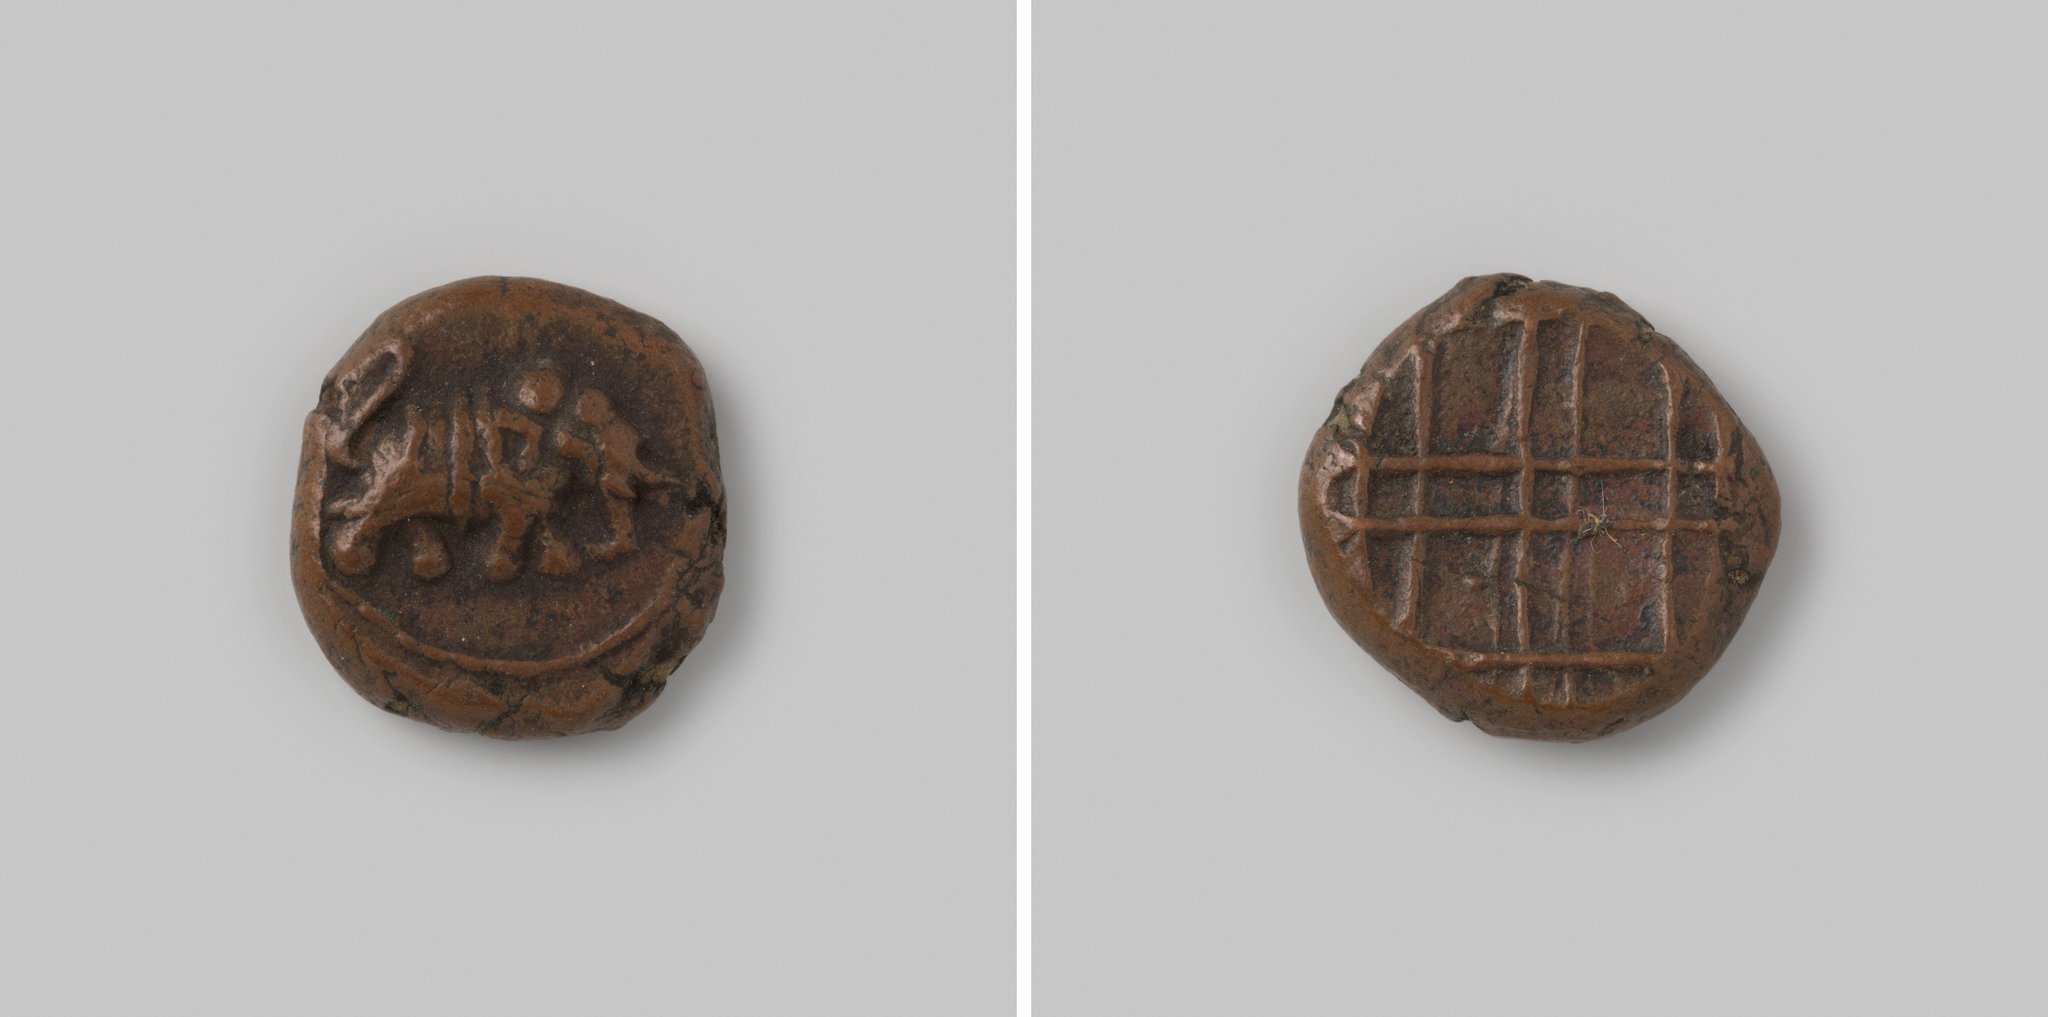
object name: coin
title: Akhtar uit Mysore in India van Kanthirava Narasa raja Wodeyar I, 1638-1659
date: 1638-1659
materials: copper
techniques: striking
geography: mysore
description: Koperen munt. Voorzijde: lopende olifant naar rechts. Keerzijde: patroon van loodrecht op elkaar staande rechte lijnen.